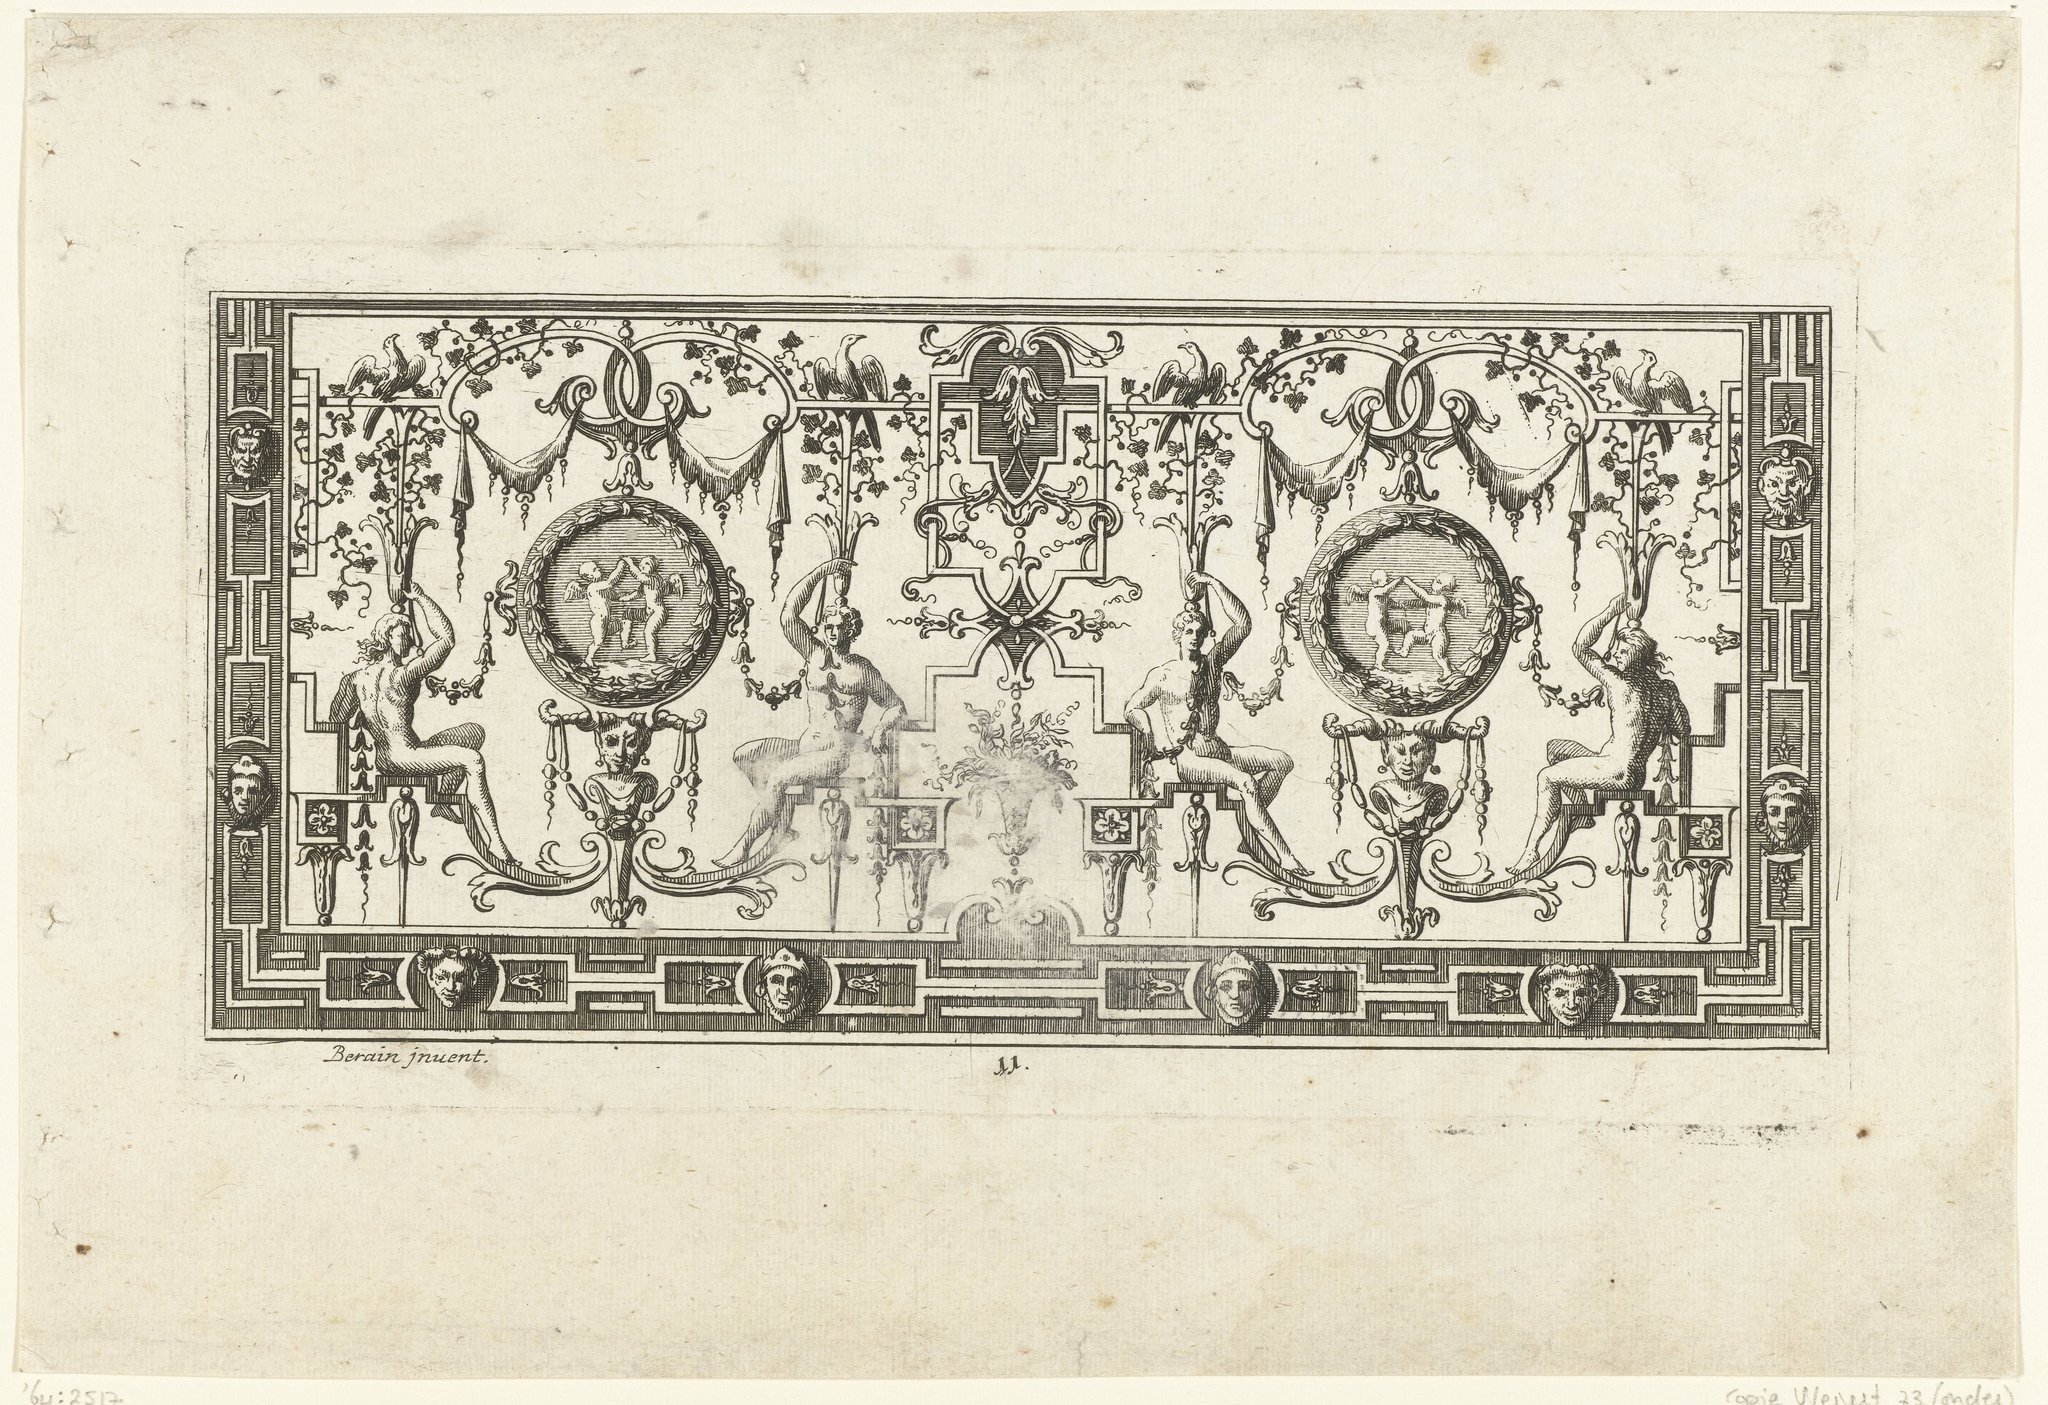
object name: print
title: Moderne grotesken met cherubijnen in bladerkransen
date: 1675-1748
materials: paper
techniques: etching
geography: france